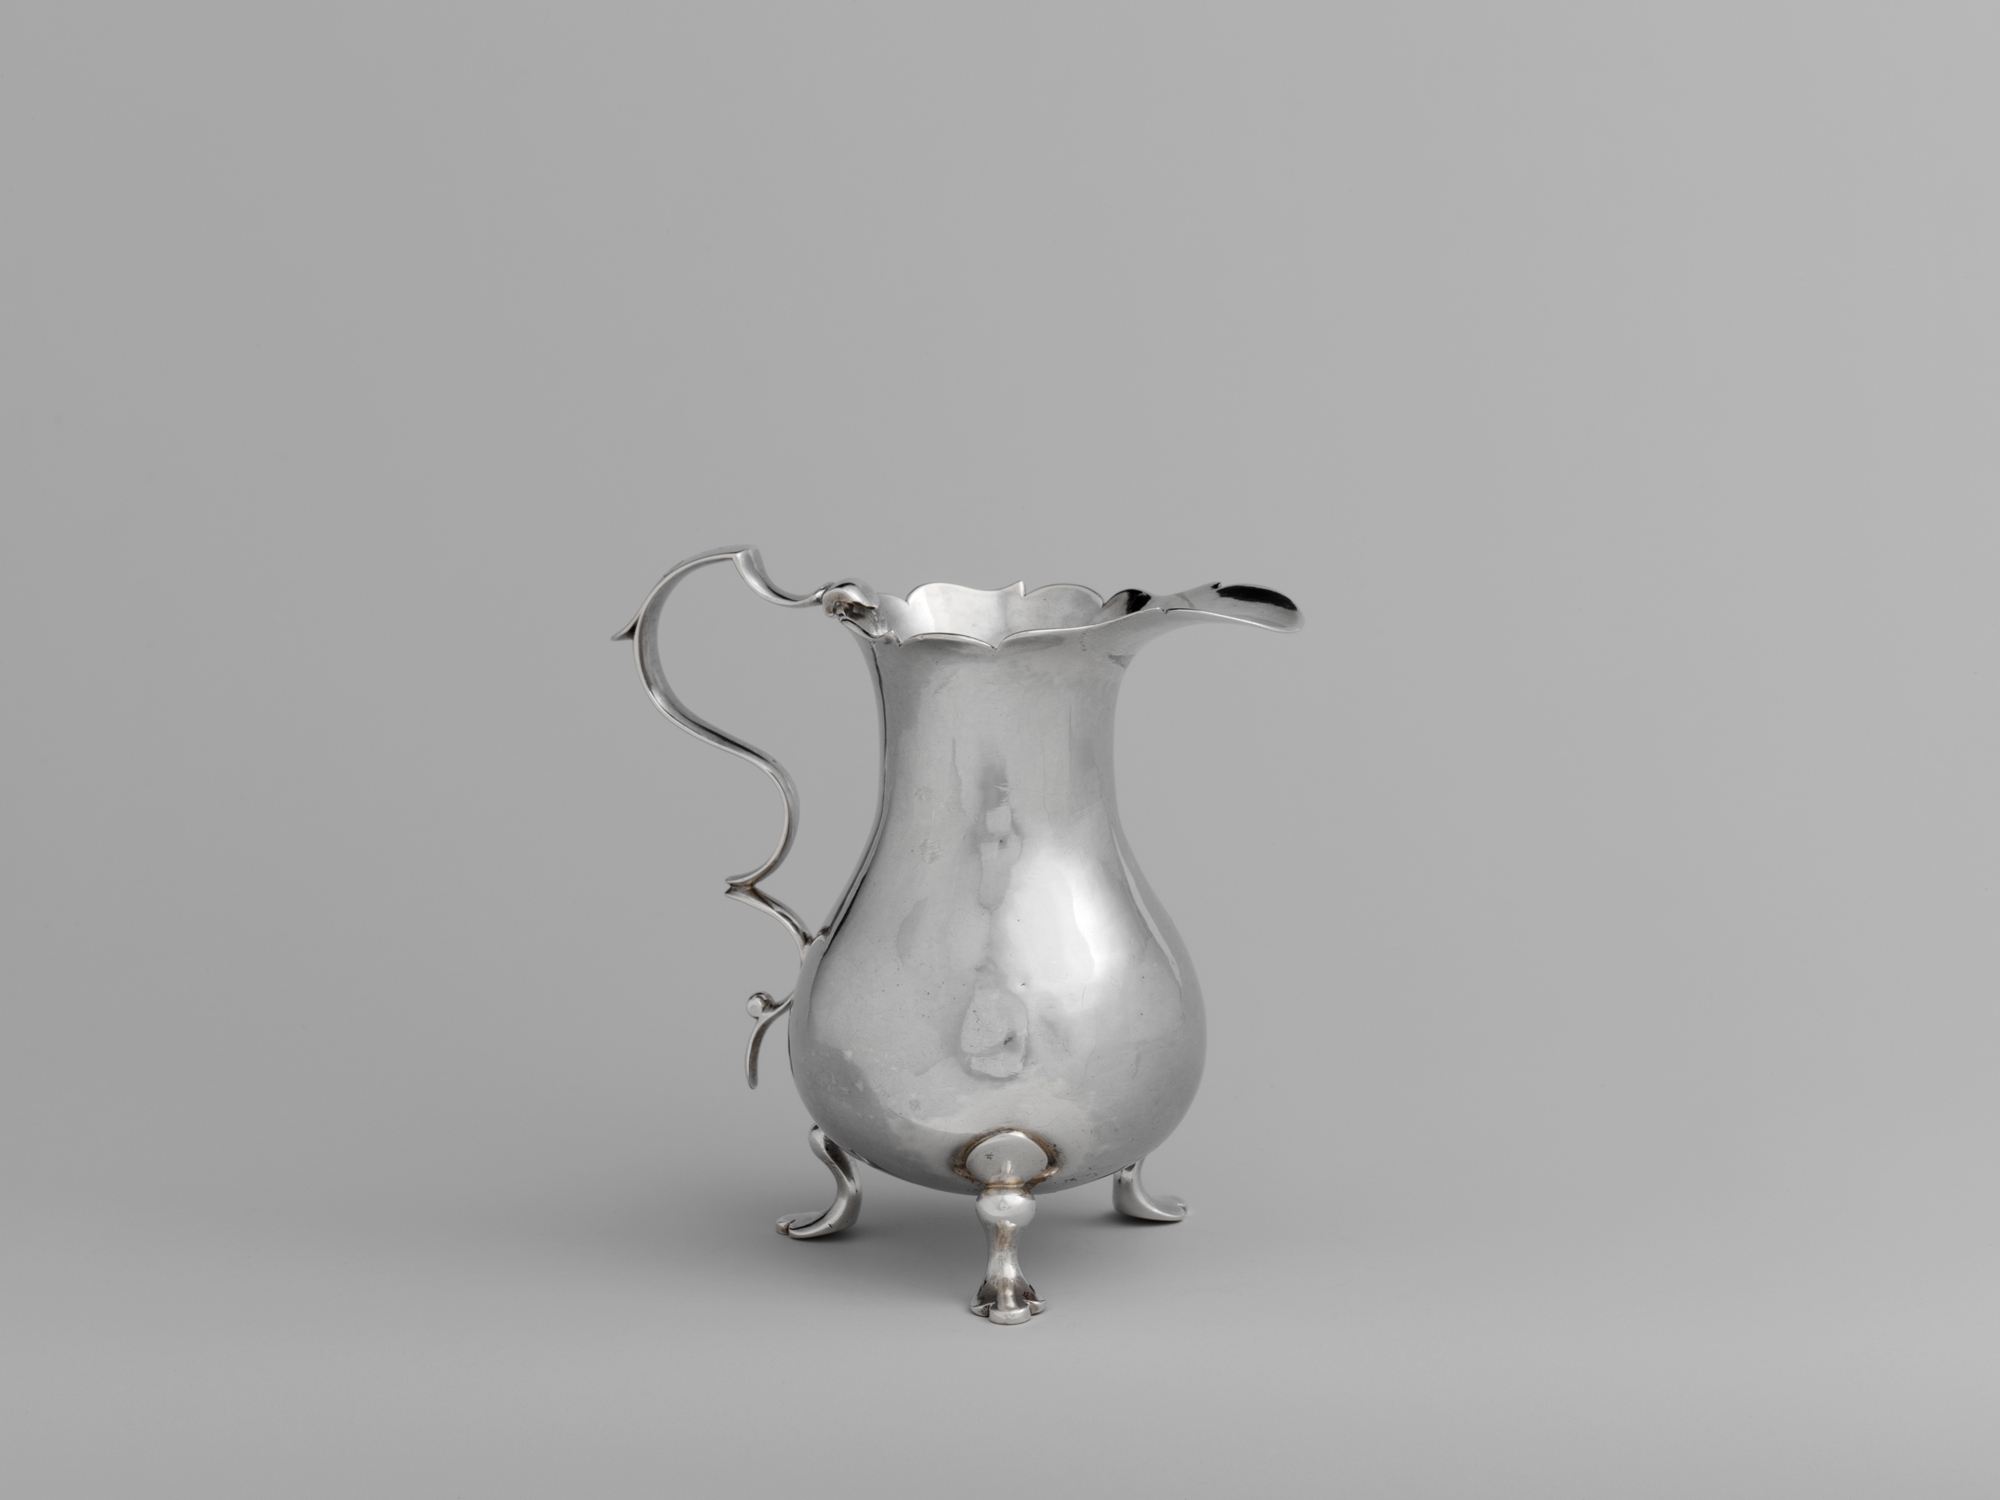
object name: cream pot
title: Creampot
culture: american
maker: benjamin burt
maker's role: maker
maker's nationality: american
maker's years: 1729-1805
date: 1755-1770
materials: silver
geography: united states